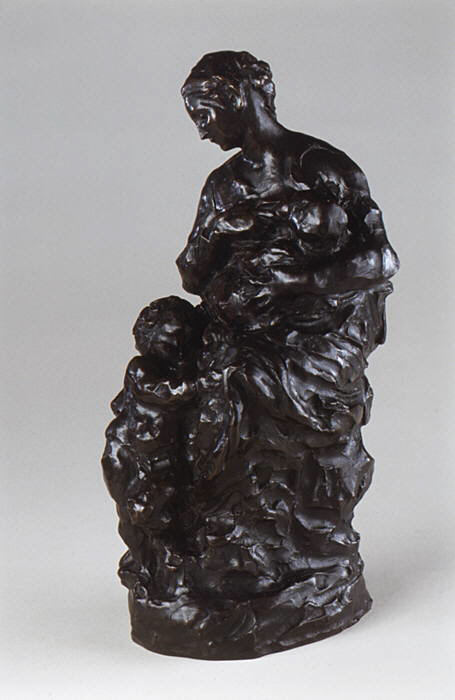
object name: statuette group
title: Charity or Maternity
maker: aimé-jules dalou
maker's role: artist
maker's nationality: french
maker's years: 1838-1902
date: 1801-1900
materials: bronze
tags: children,women